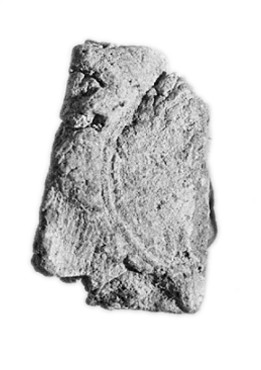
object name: sealing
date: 1981-1640 BCE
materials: mud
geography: egypt